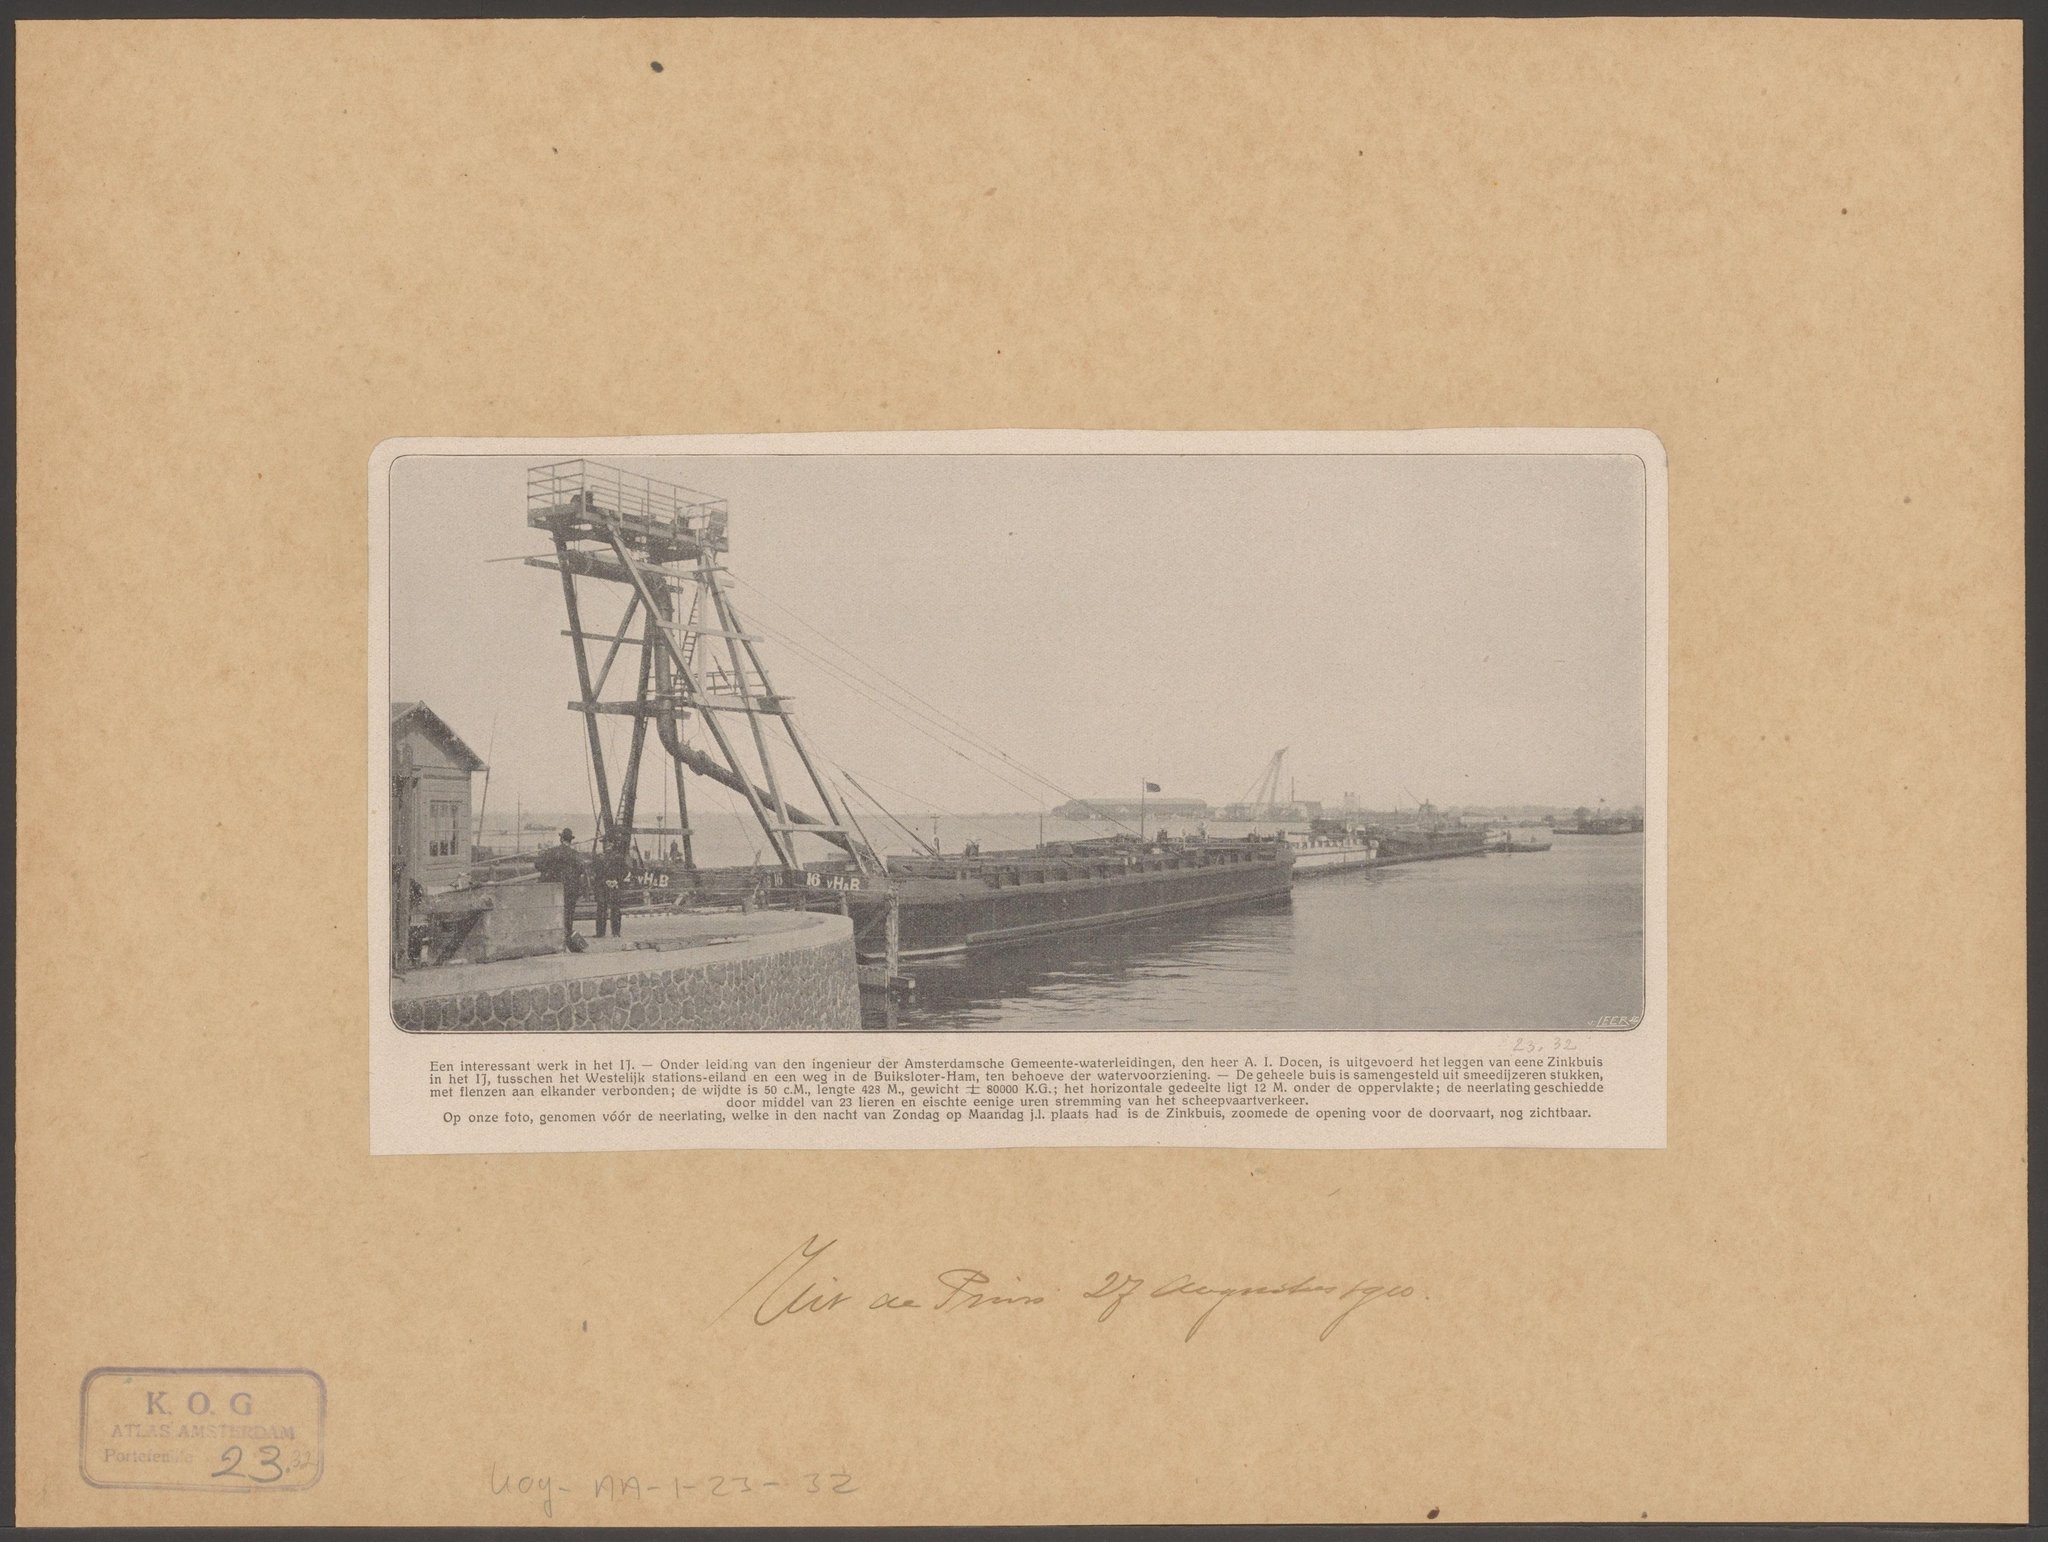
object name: photomechanical print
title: Aanleg van een waterleiding in het IJ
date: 1910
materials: paper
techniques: letterpress printing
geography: netherlands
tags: steamship, motorship, pipe system (~ water supply)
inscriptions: collector's mark: Lugt 1641b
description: Onderwerpsrubriek binnen de Atlas Amsterdam: Gemeentebedrijven.